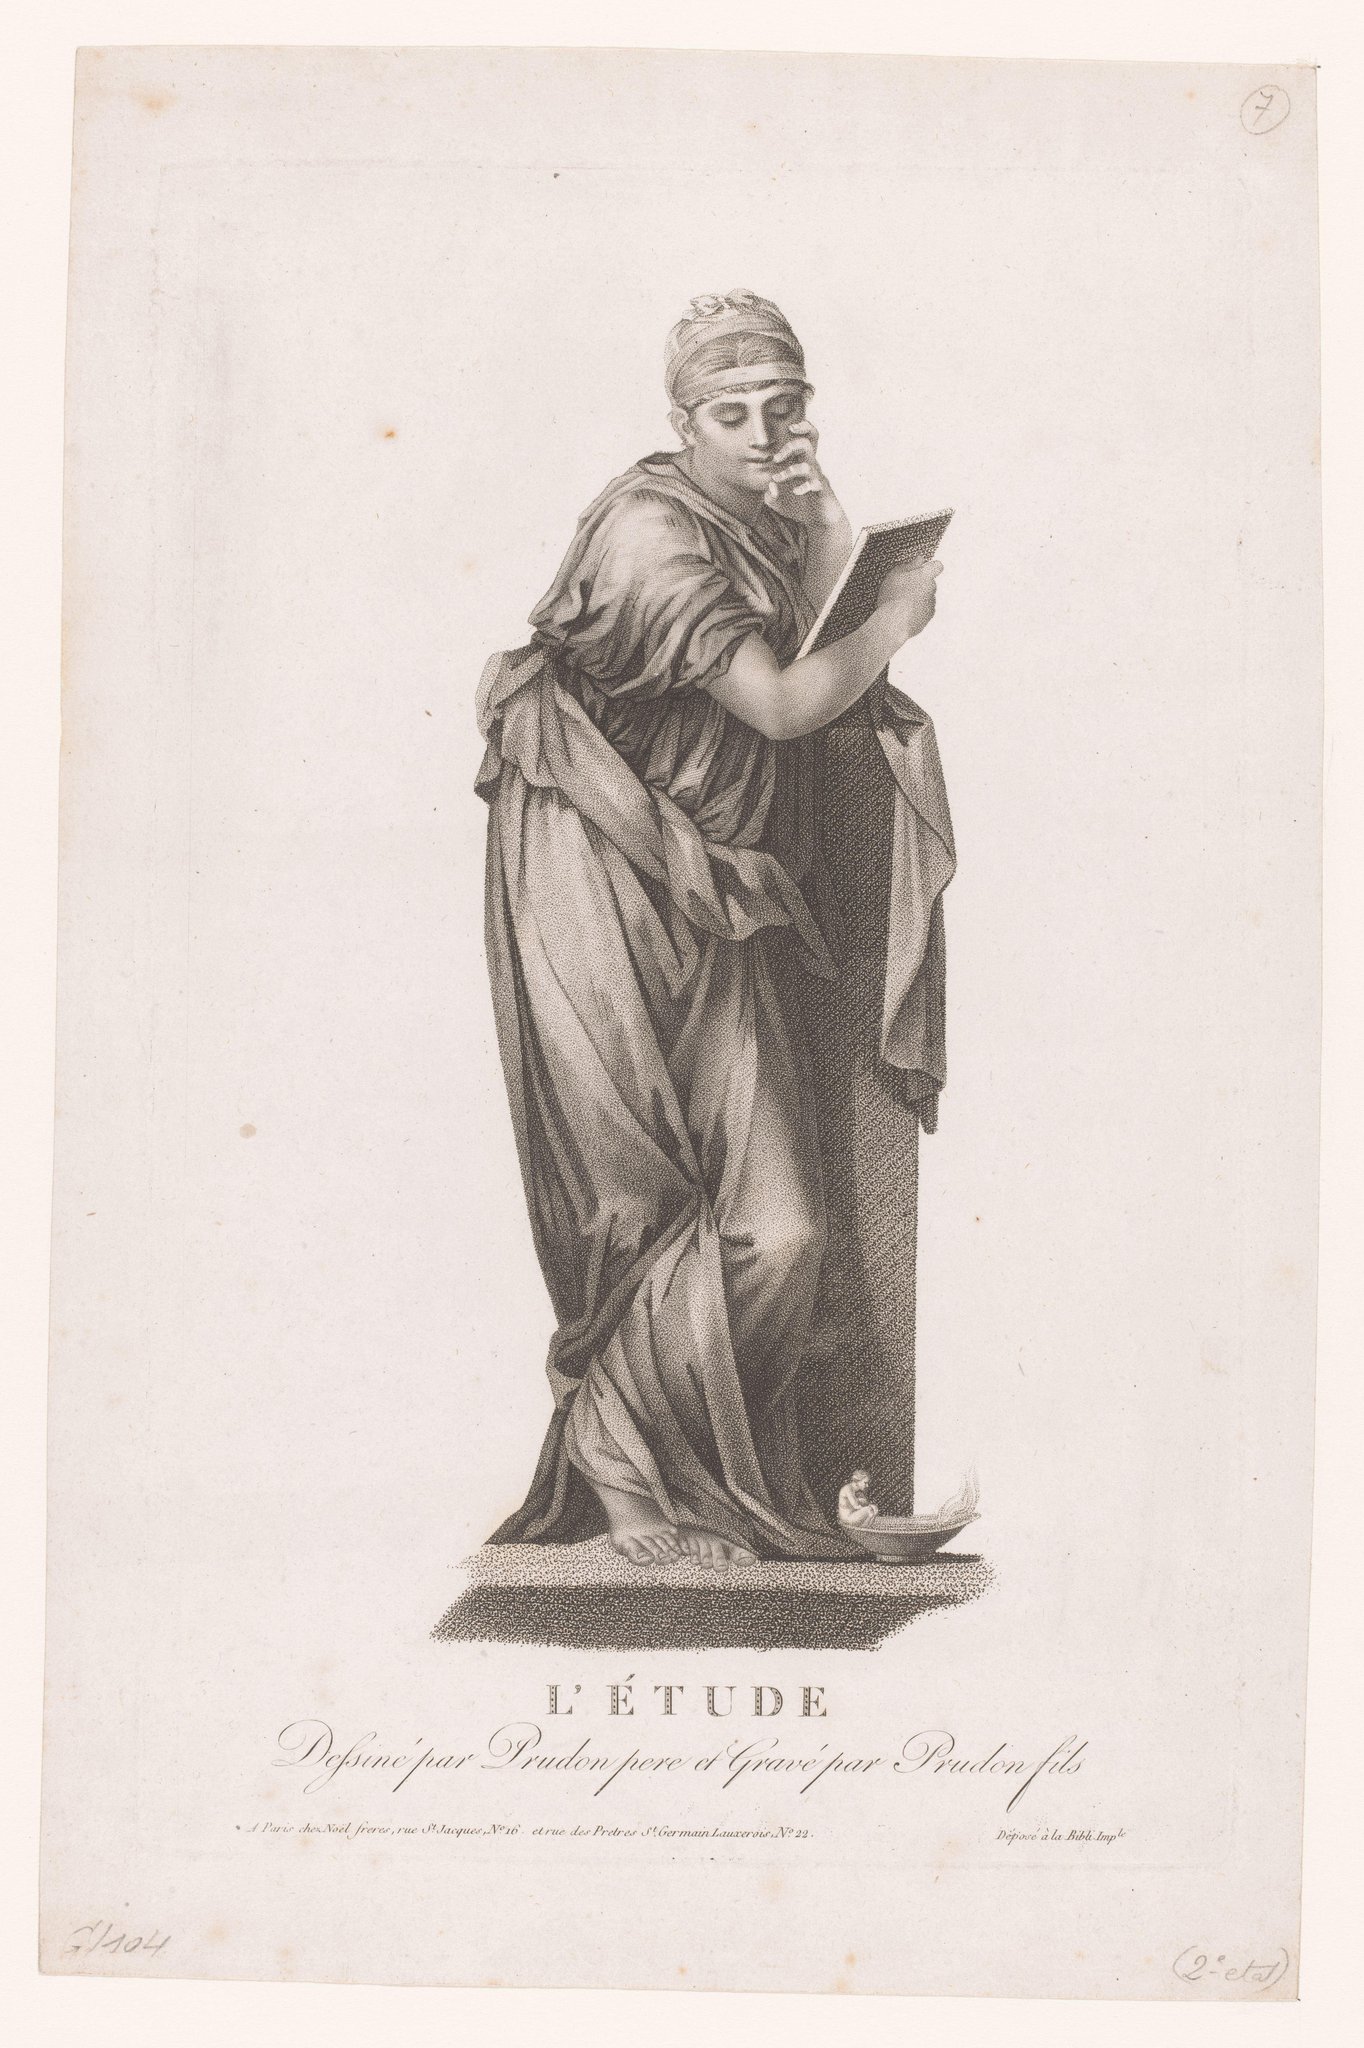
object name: print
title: Decoraties voor het stadhuis tijdens het huwelijk van Napoleon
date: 1810-1823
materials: paper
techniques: engraving, etching, roulette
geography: paris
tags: 49a1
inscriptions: collector's mark: Lugt 2228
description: Serie naar de figuren die als decoratie gebruikt zijn in het stadhuis, tijdens het huwelijk van Napoleon I Bonaparte en Marie Louise van Oostenrijk in 1810.